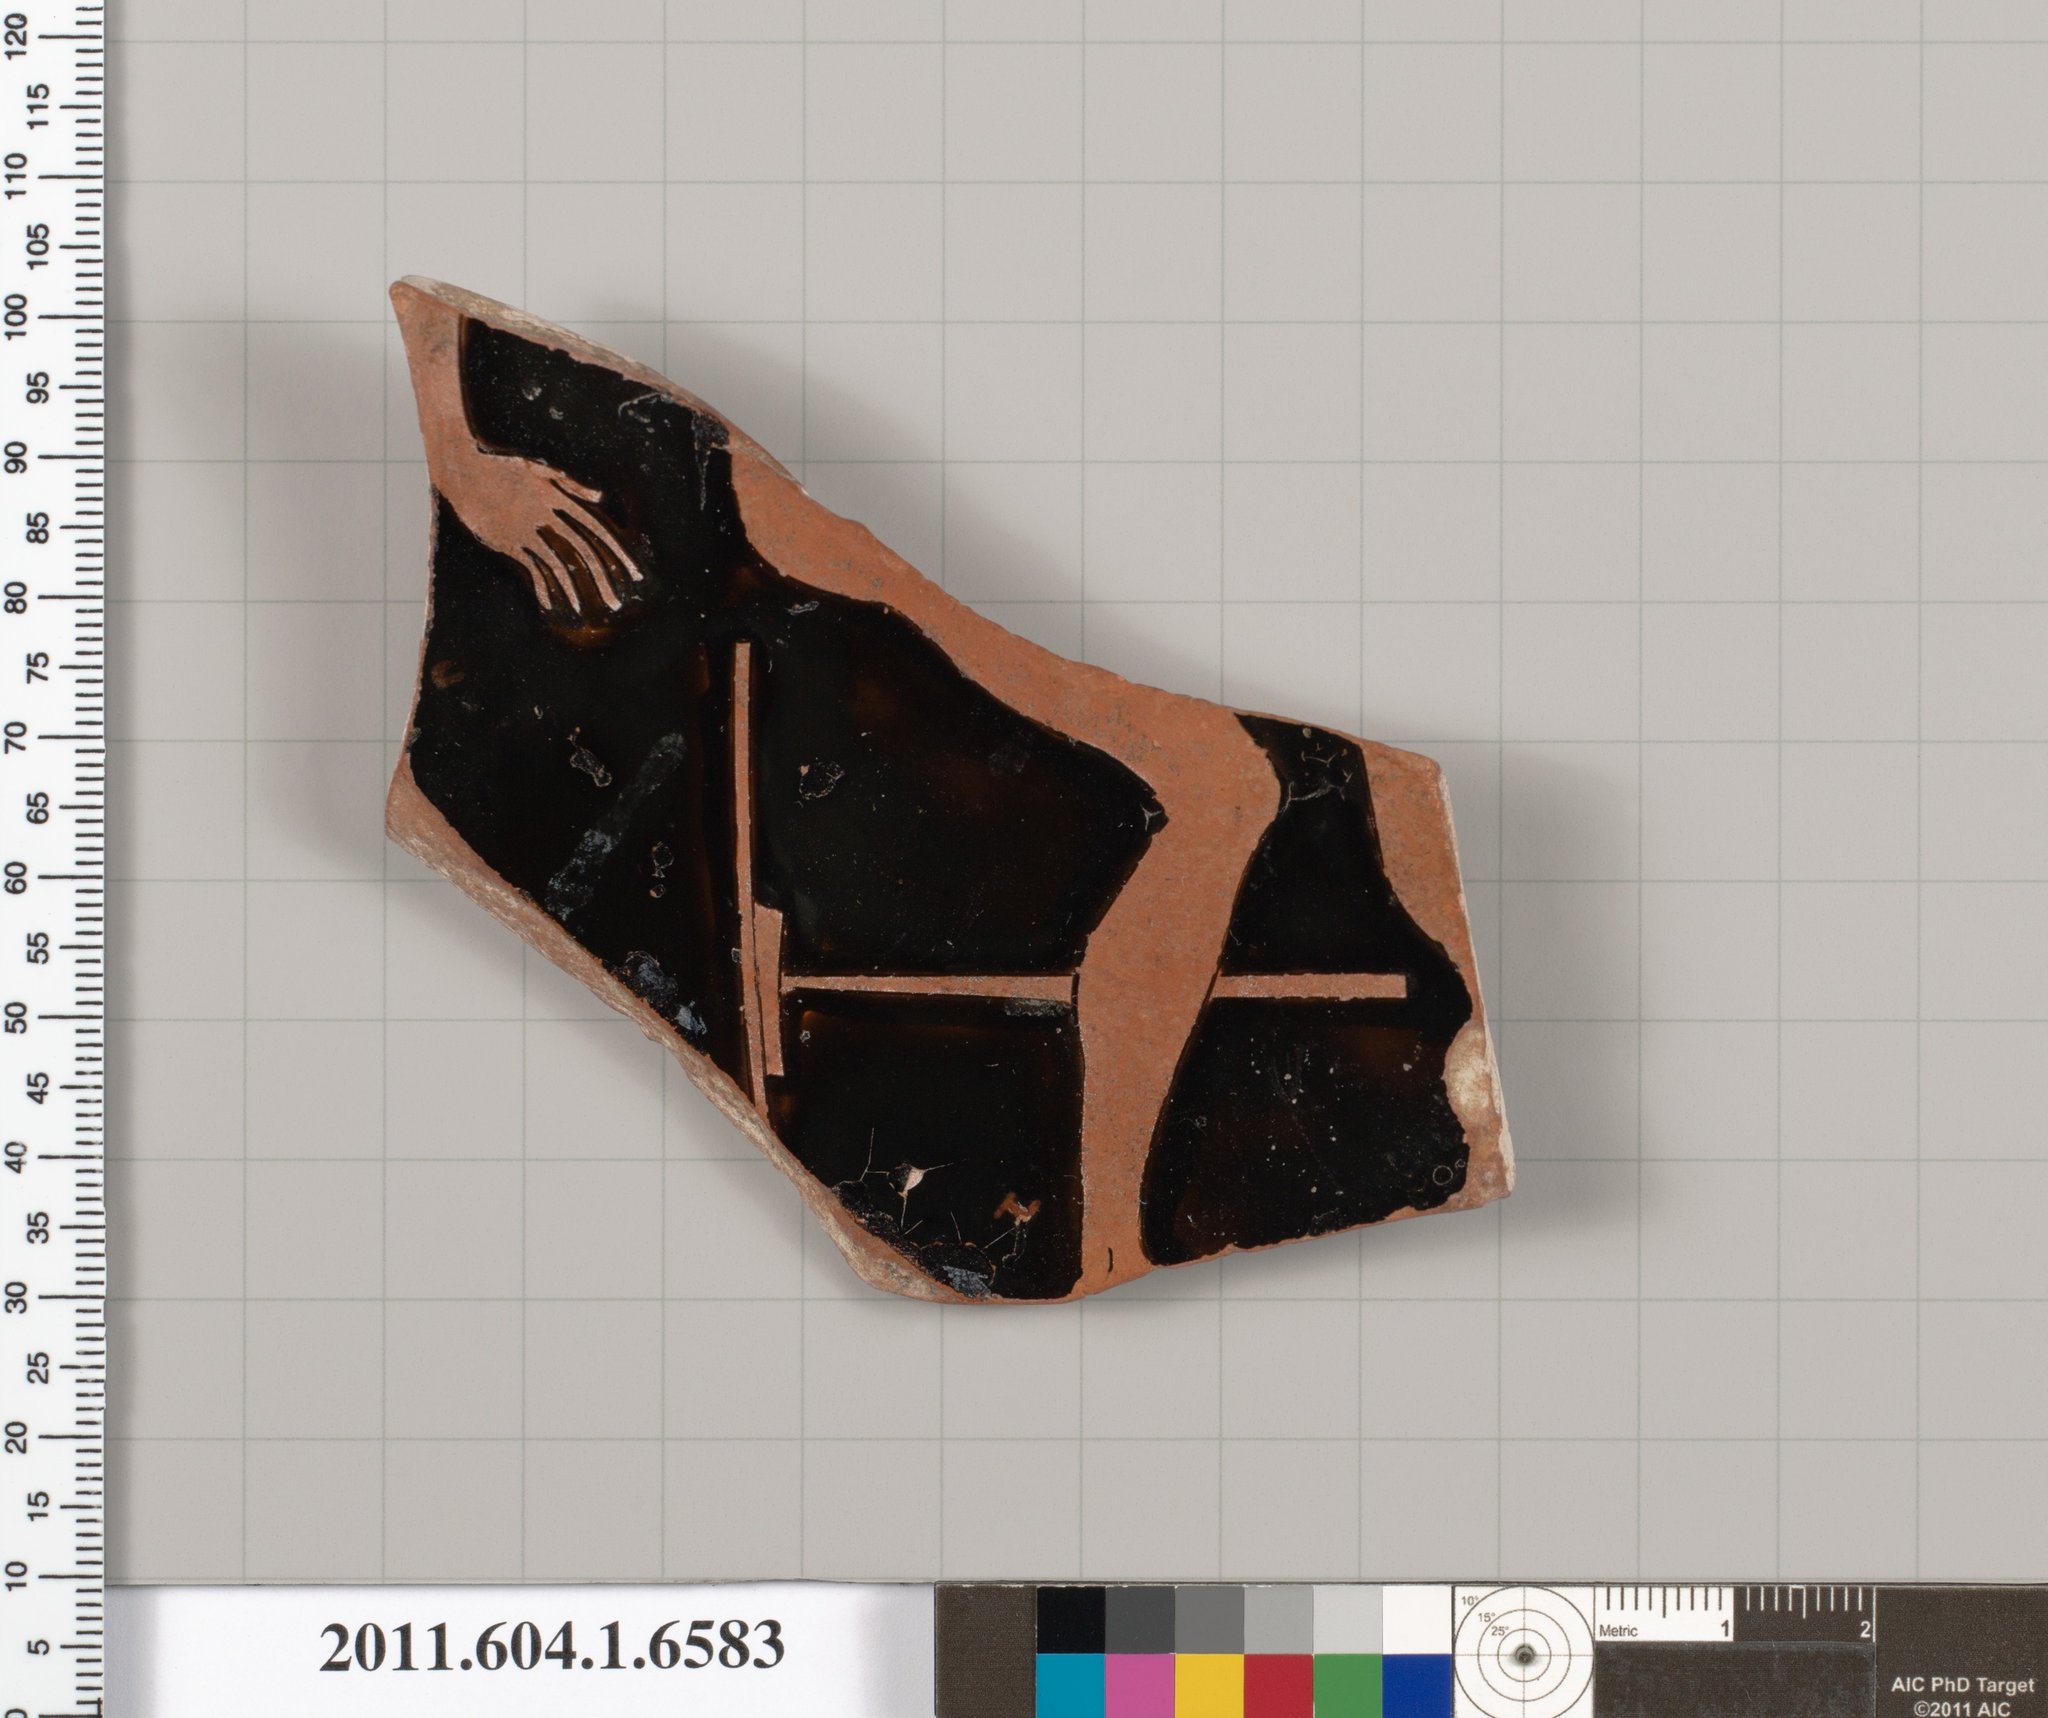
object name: kylix fragment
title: Terracotta fragment of a kylix (drinking cup)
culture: greek, attic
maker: triptolemos painter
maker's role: artist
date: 490-480 BCE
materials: terracotta